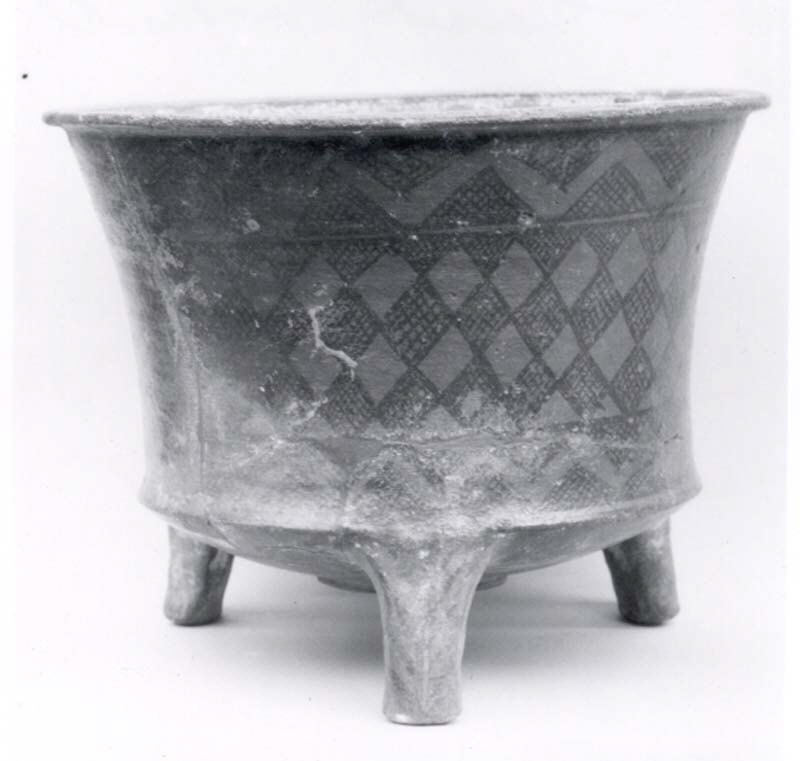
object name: bowl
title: Tripod bowl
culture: iranian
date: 2000-1600 BCE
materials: ceramic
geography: iran, luristan